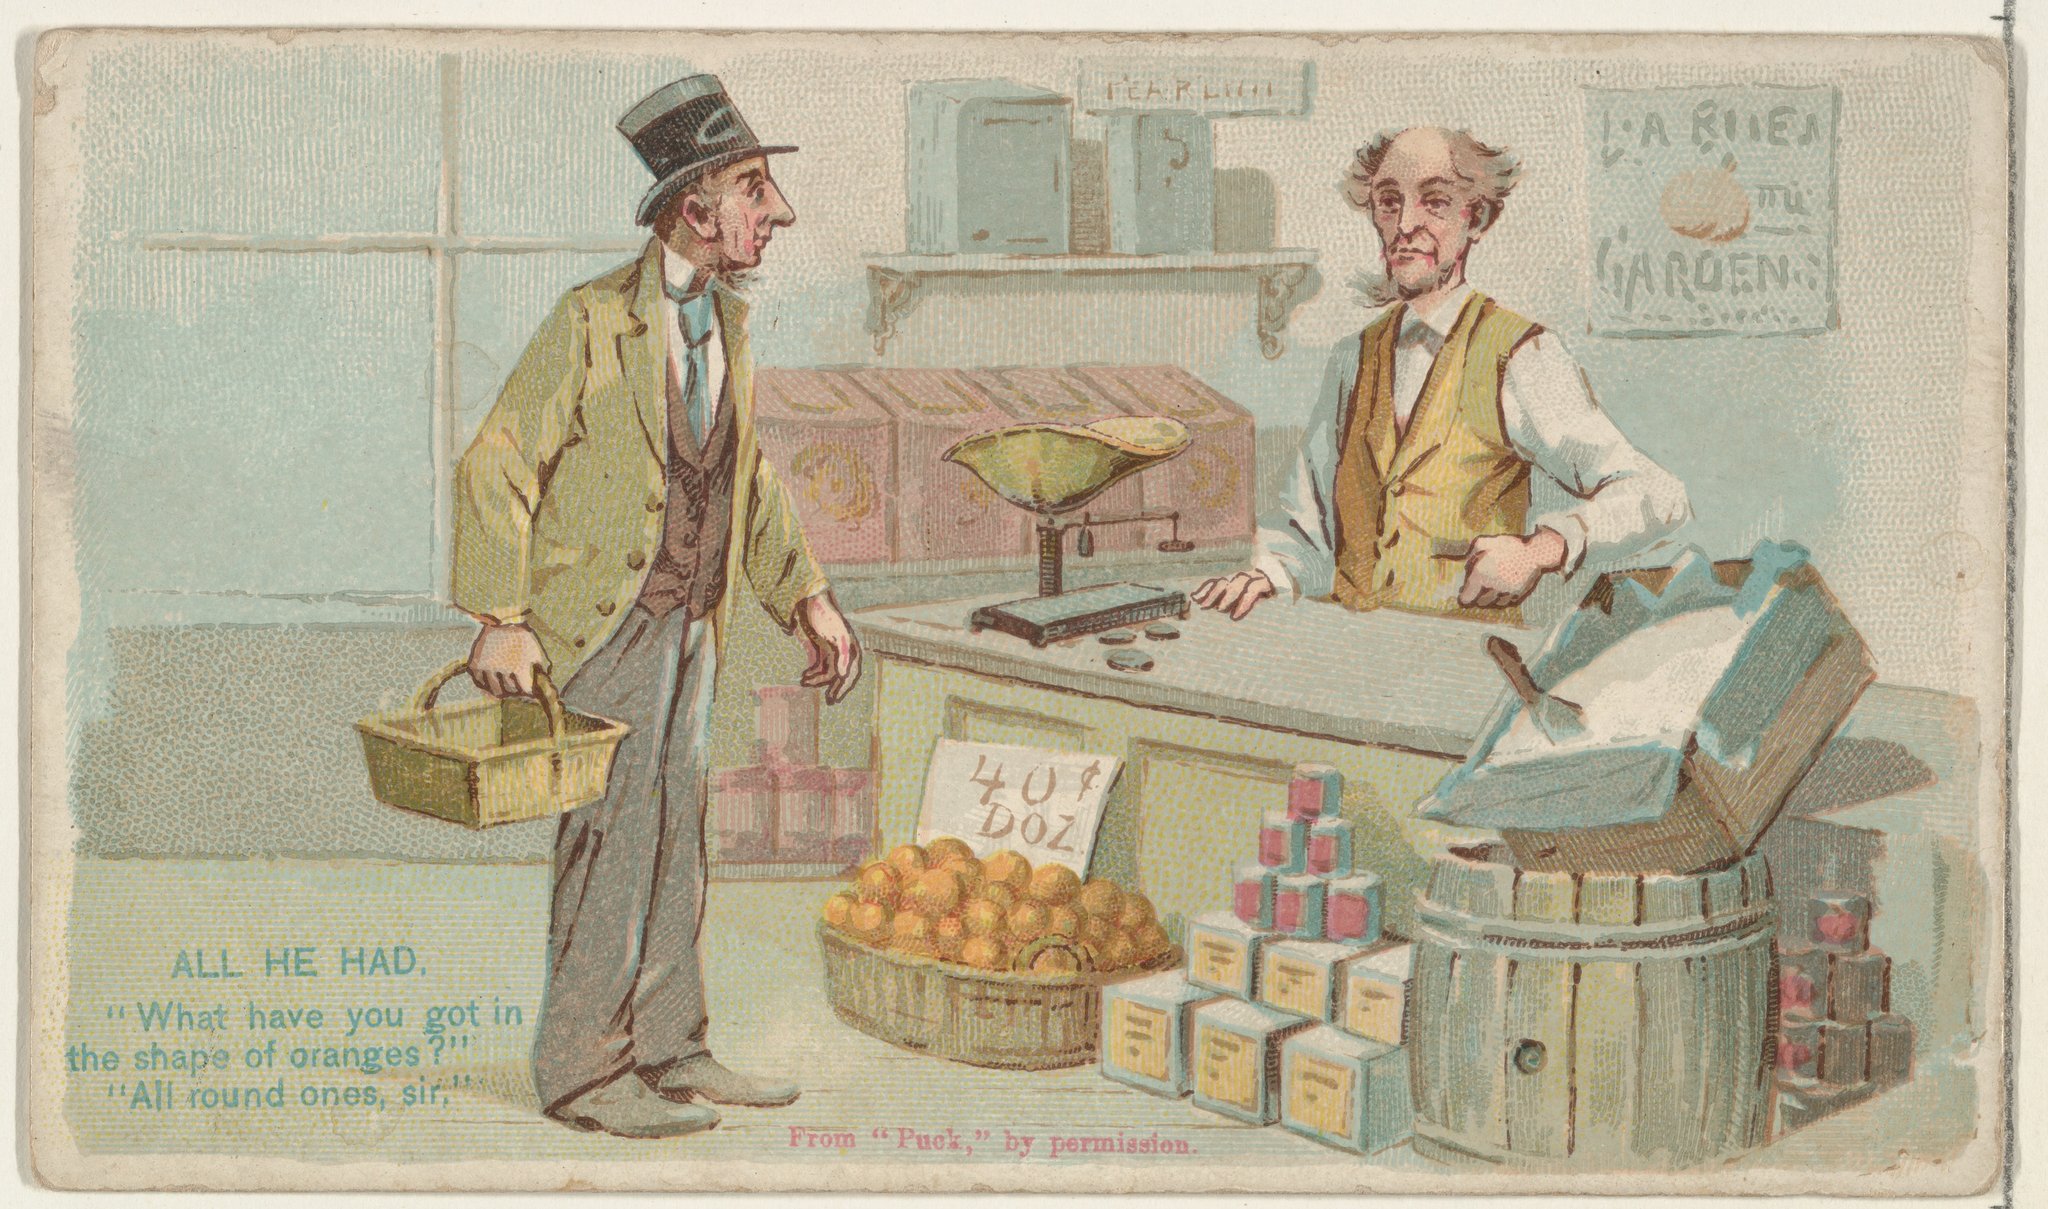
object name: print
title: All He Had, from the Snapshots from "Puck" series (N128) issued by Duke Sons & Co. to promote Honest Long Cut Tobacco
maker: w. duke, sons & co.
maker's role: publisher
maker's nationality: american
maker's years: 1870-1920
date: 1888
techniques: color lithograph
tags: fruit,men,scales